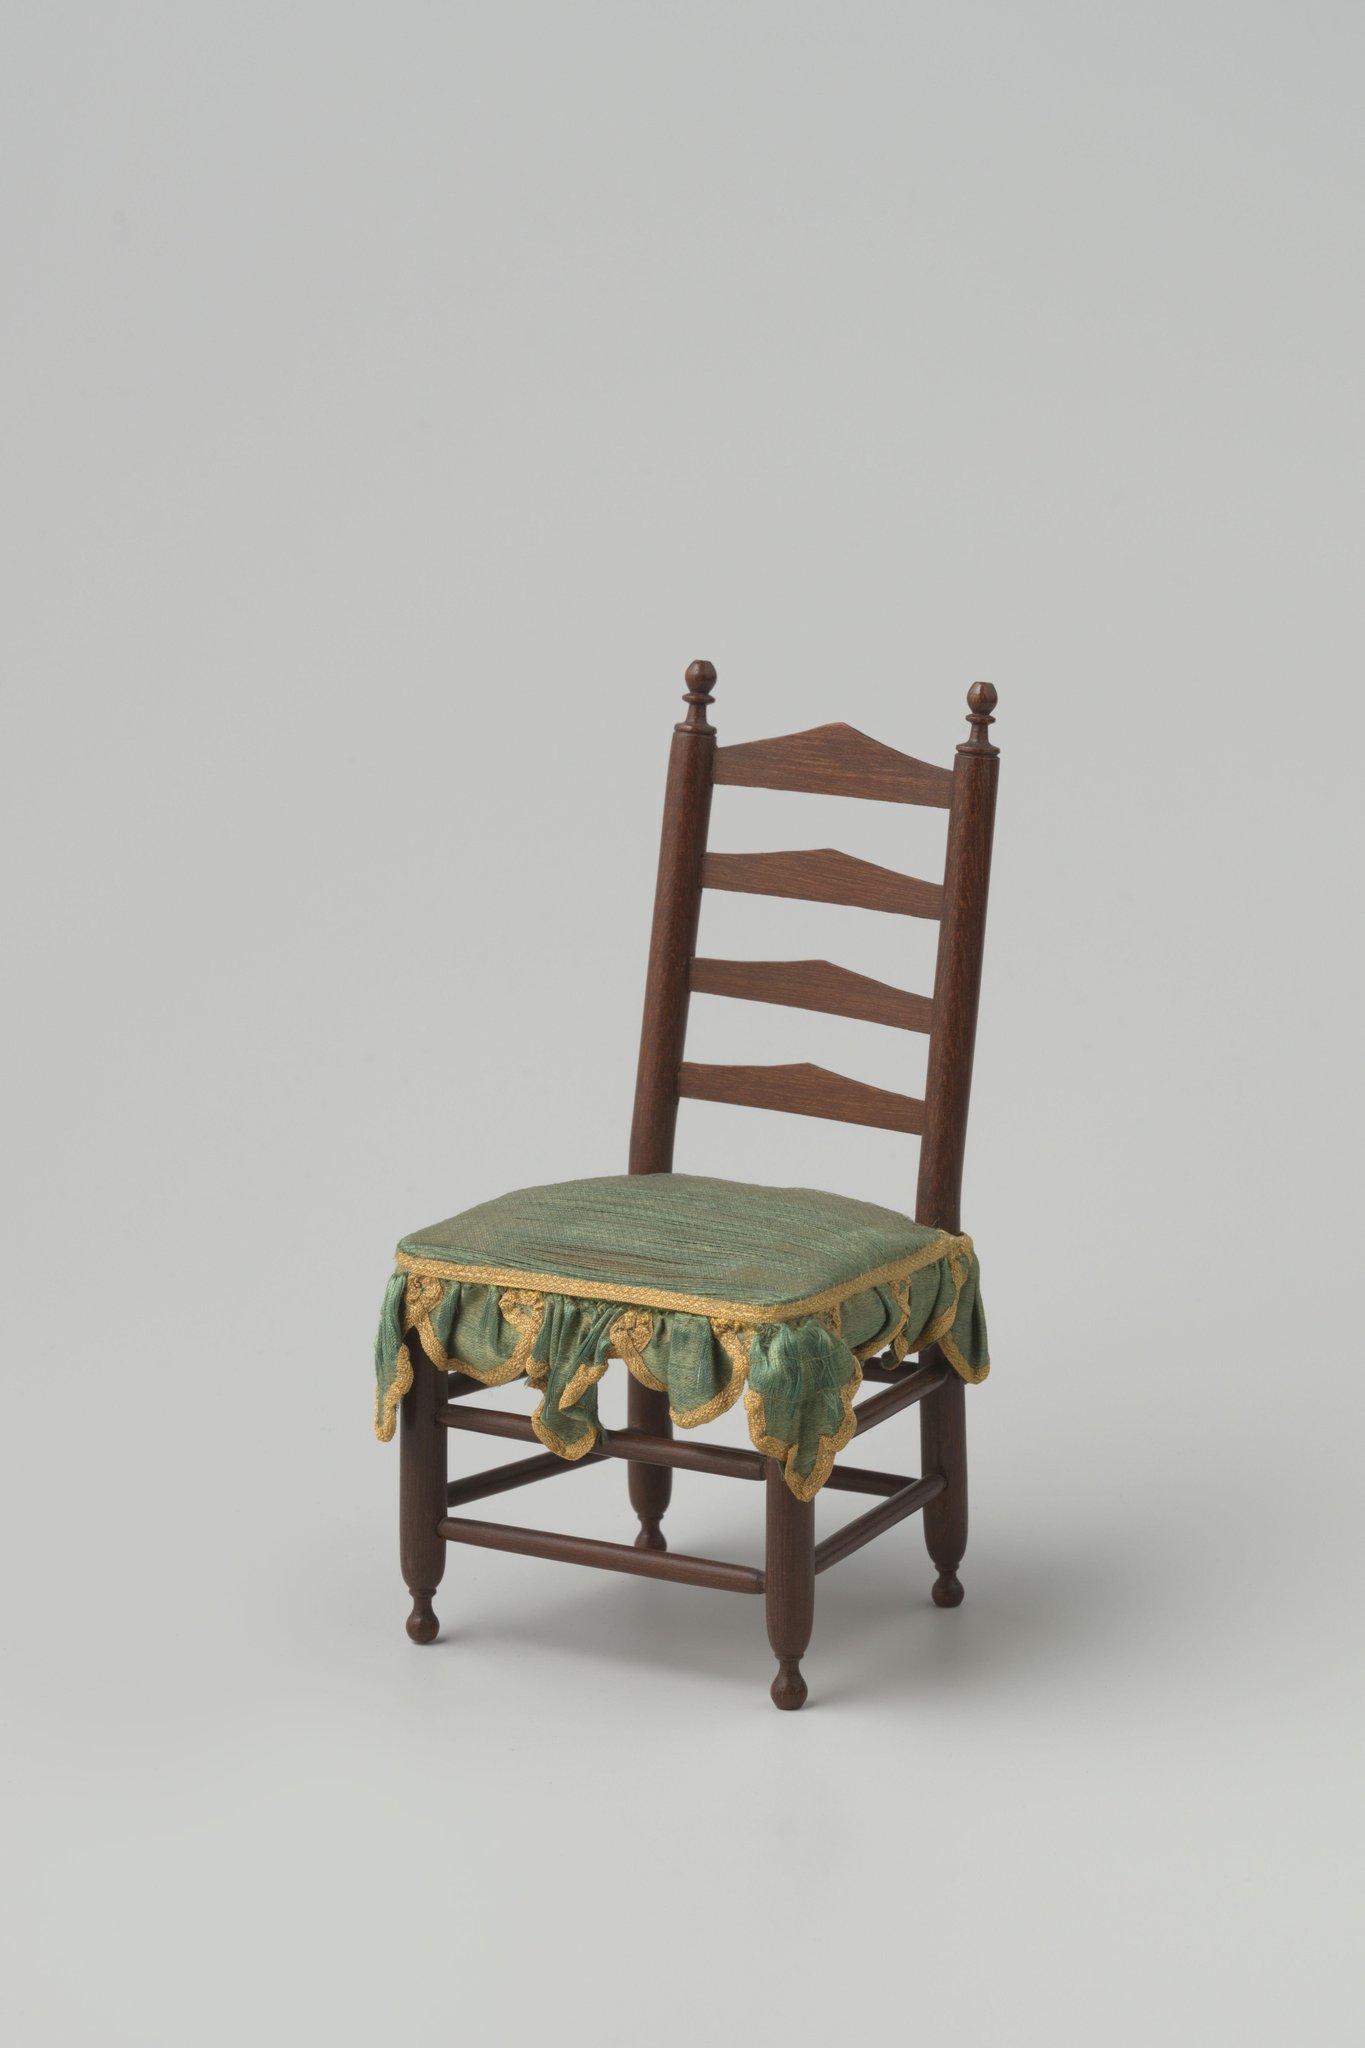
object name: knopstoel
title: Knopstoel vervaardigd van hardhout met gladde, gedraaide stijlen en dwarsregels, voorpoten en achterstijlen eindigend in fijn gedraaide knoppen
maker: Anonymous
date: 1690-1710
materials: wood, silk, fiber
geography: amsterdam